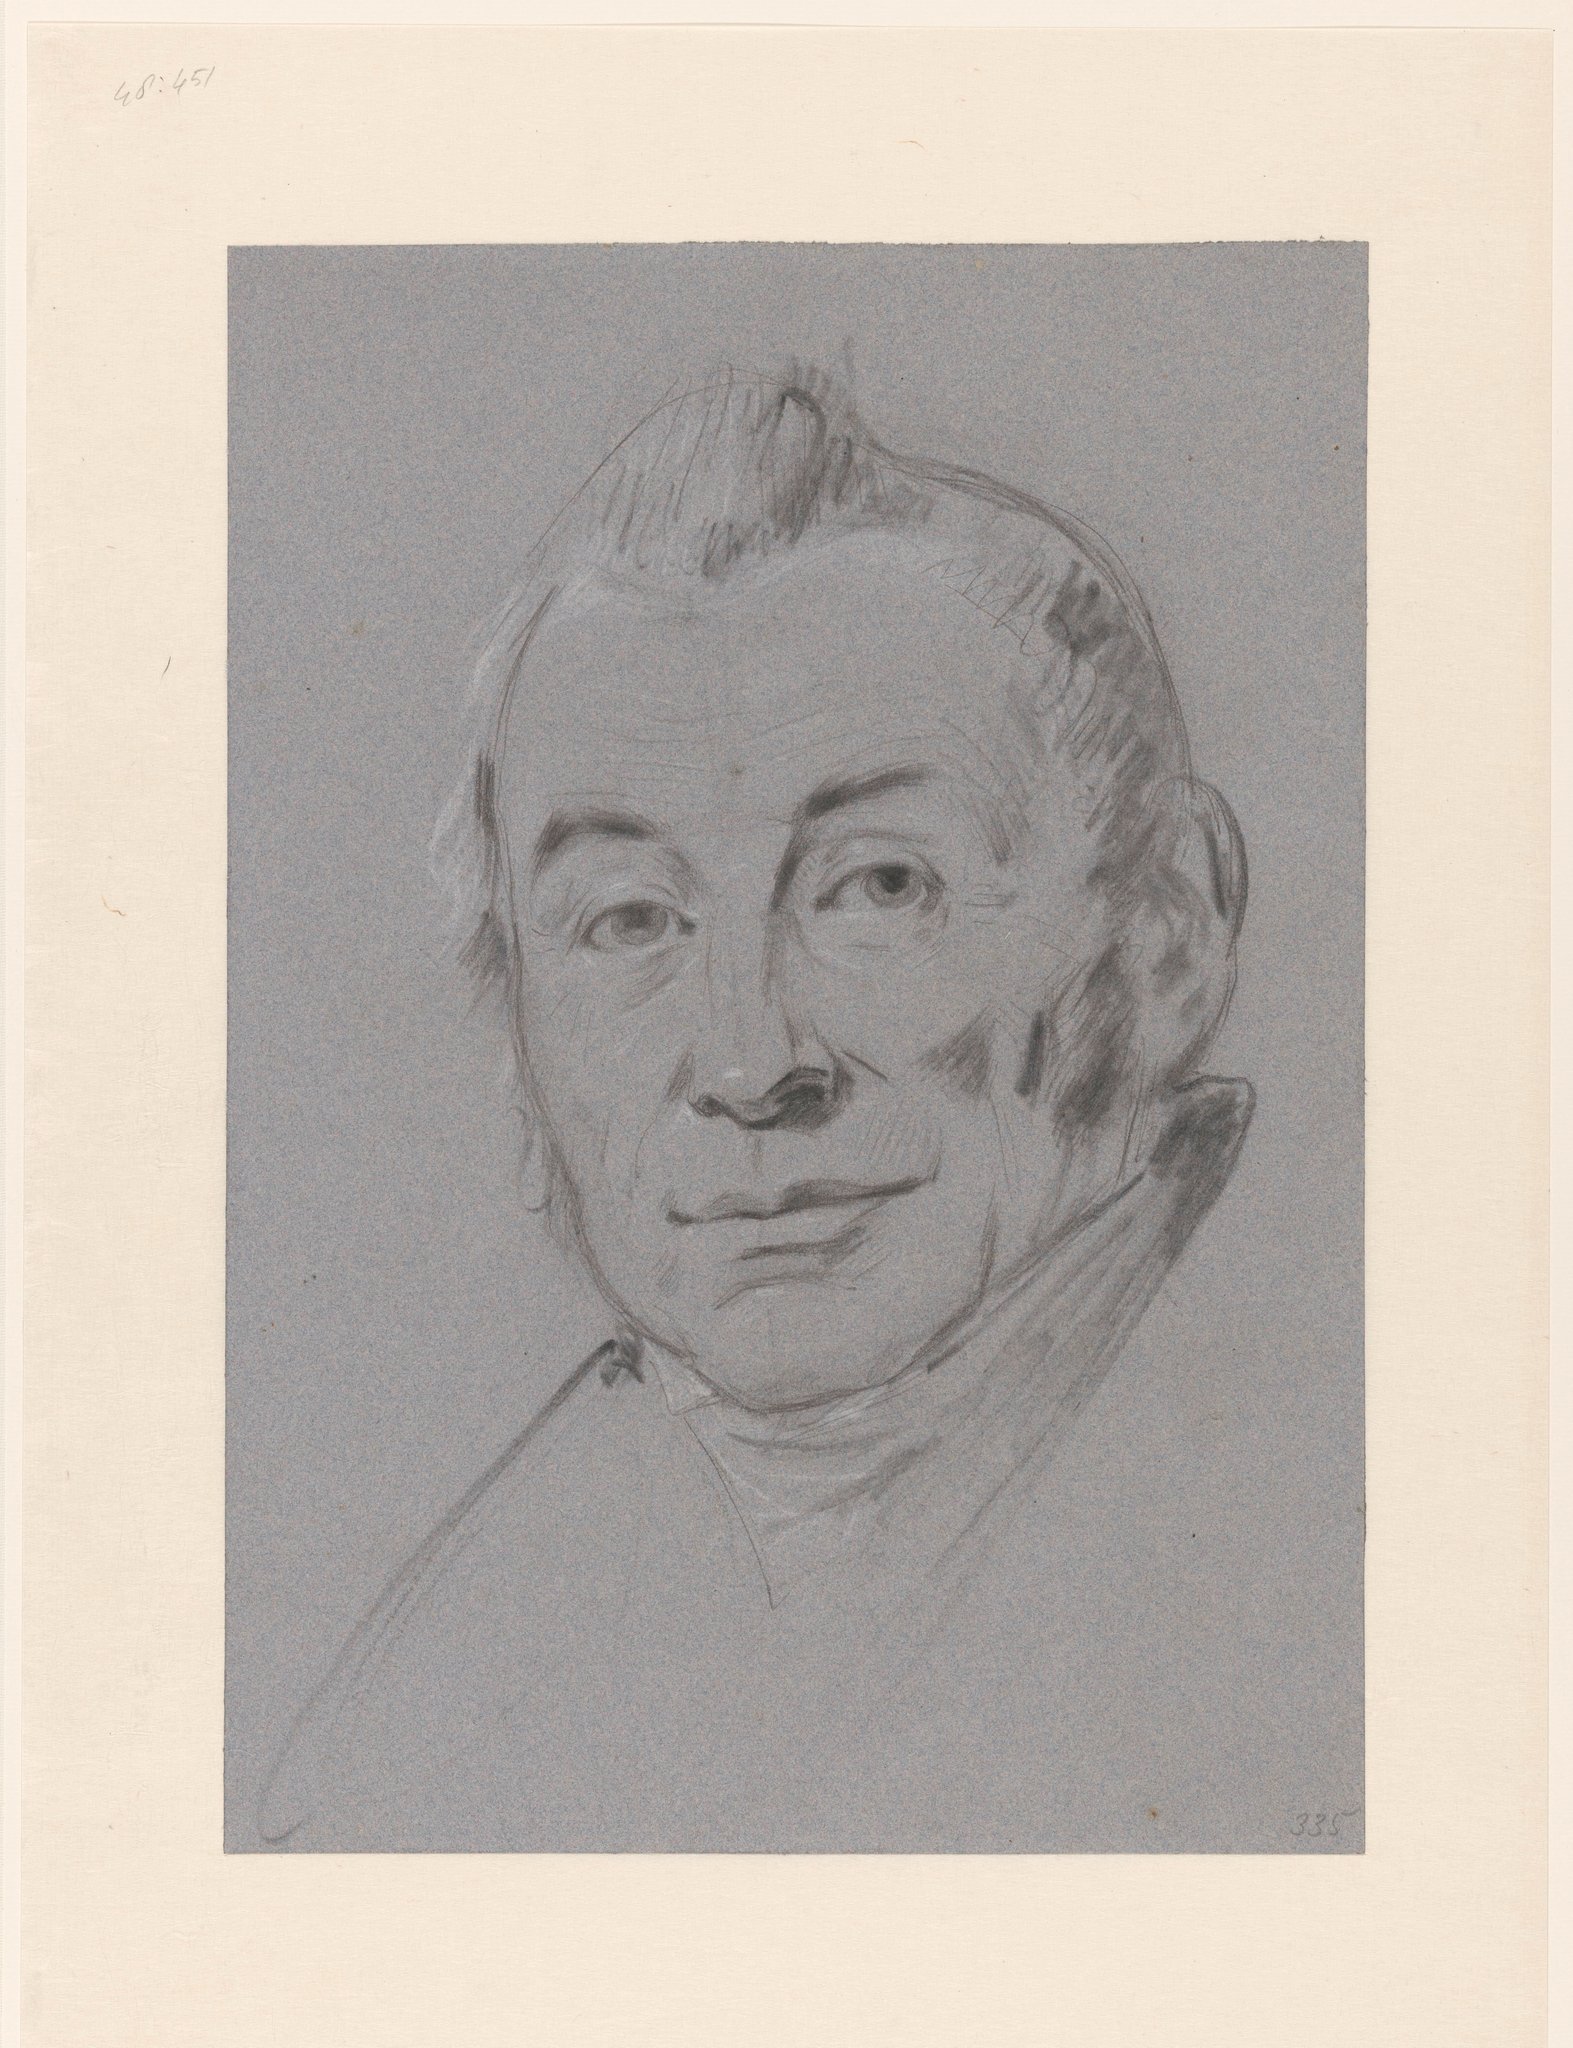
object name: drawing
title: Portret van een man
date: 1814-1862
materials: chalk, charcoal, paper, pencil